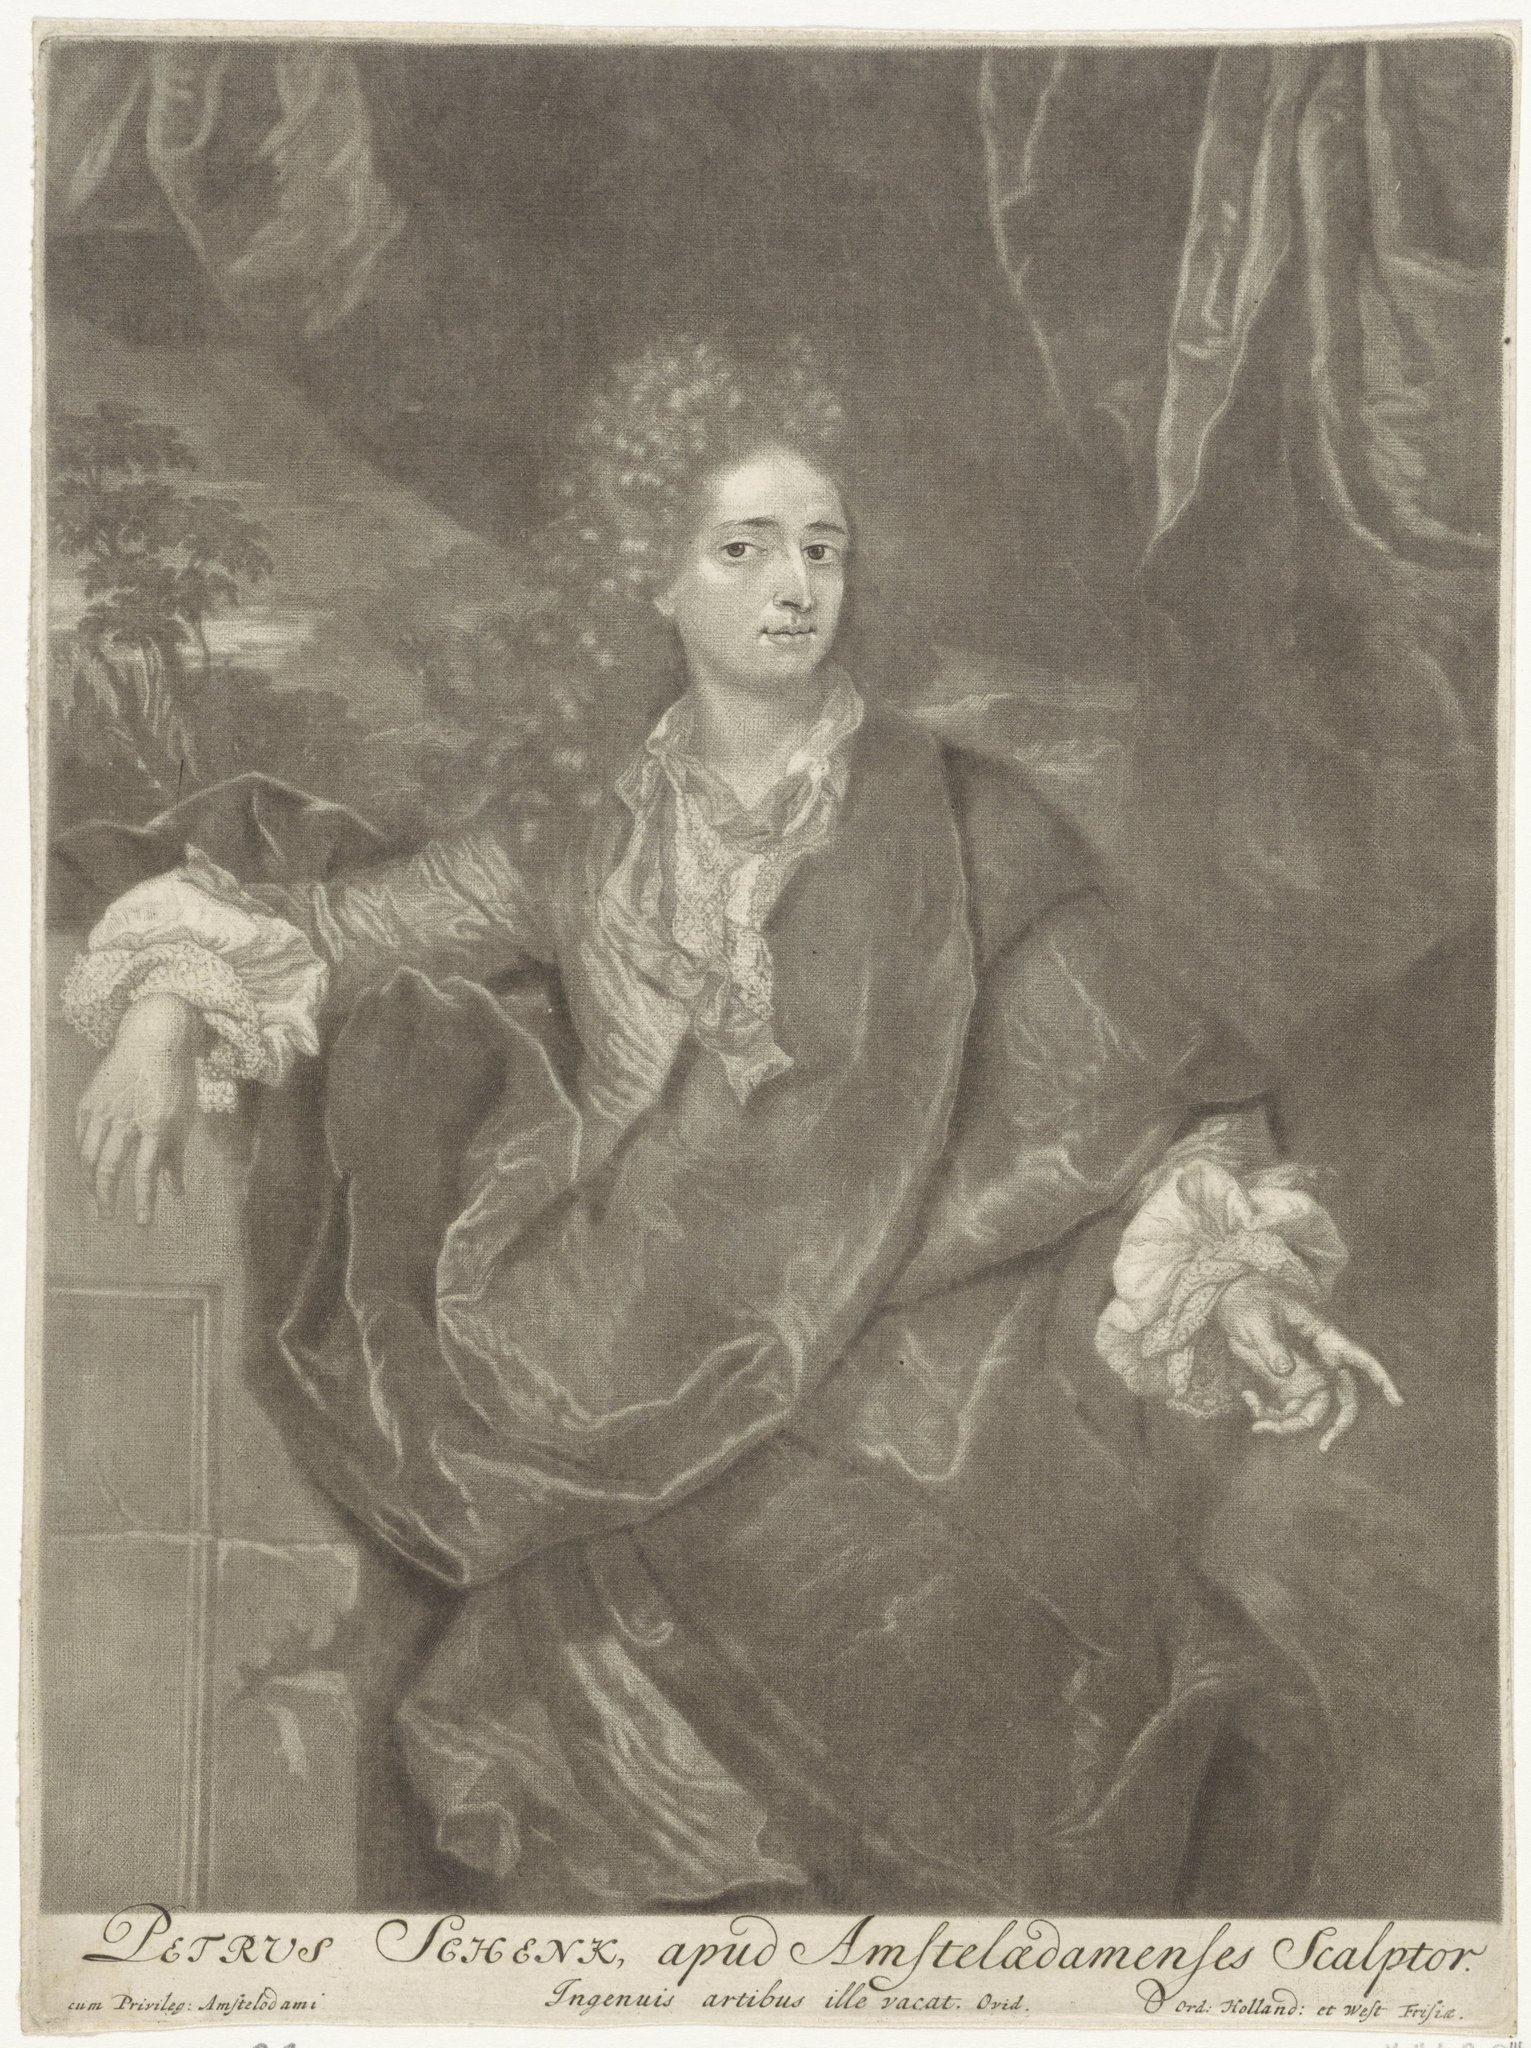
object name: print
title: Zelfportret van Pieter Schenk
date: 1680-1713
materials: paper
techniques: engraving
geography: amsterdam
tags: print maker, pieter schenk (i), portrait, self-portrait of painter, portrait, self-portrait of artist, wig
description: De prentmaker en uitgever Pieter Schenk staat voor een draperie. Op de achtergrond een landschap.